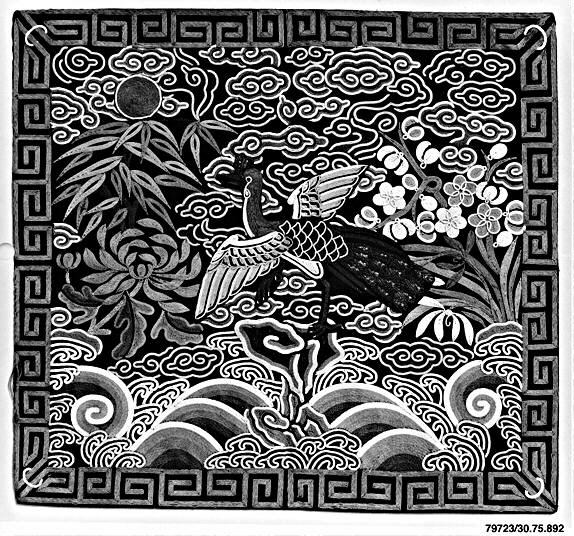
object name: woman's rank badge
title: Woman's Rank Badge with Peacock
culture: chinese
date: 1767-1833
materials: silk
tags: peacocks,flowers,plants